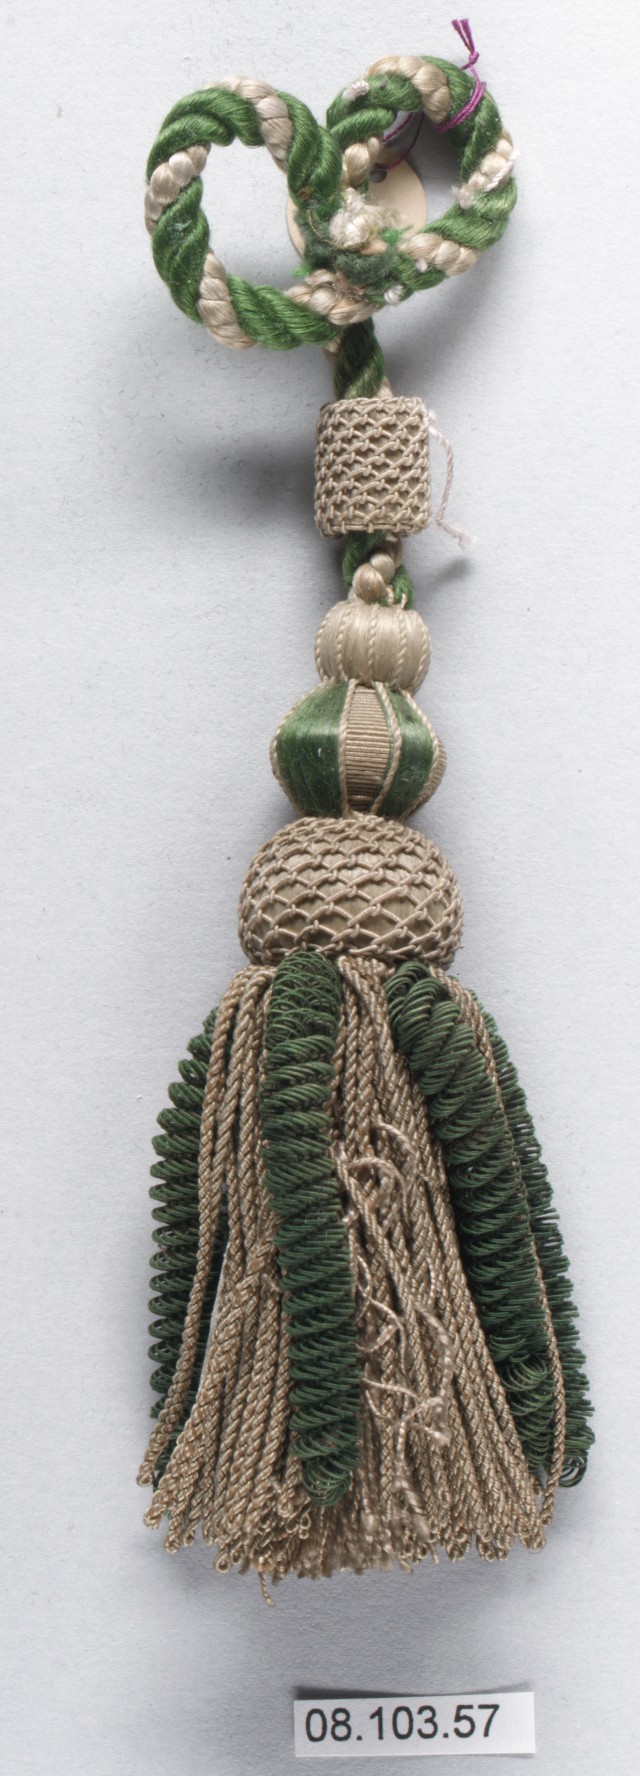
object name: tassel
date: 1801-1900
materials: silk